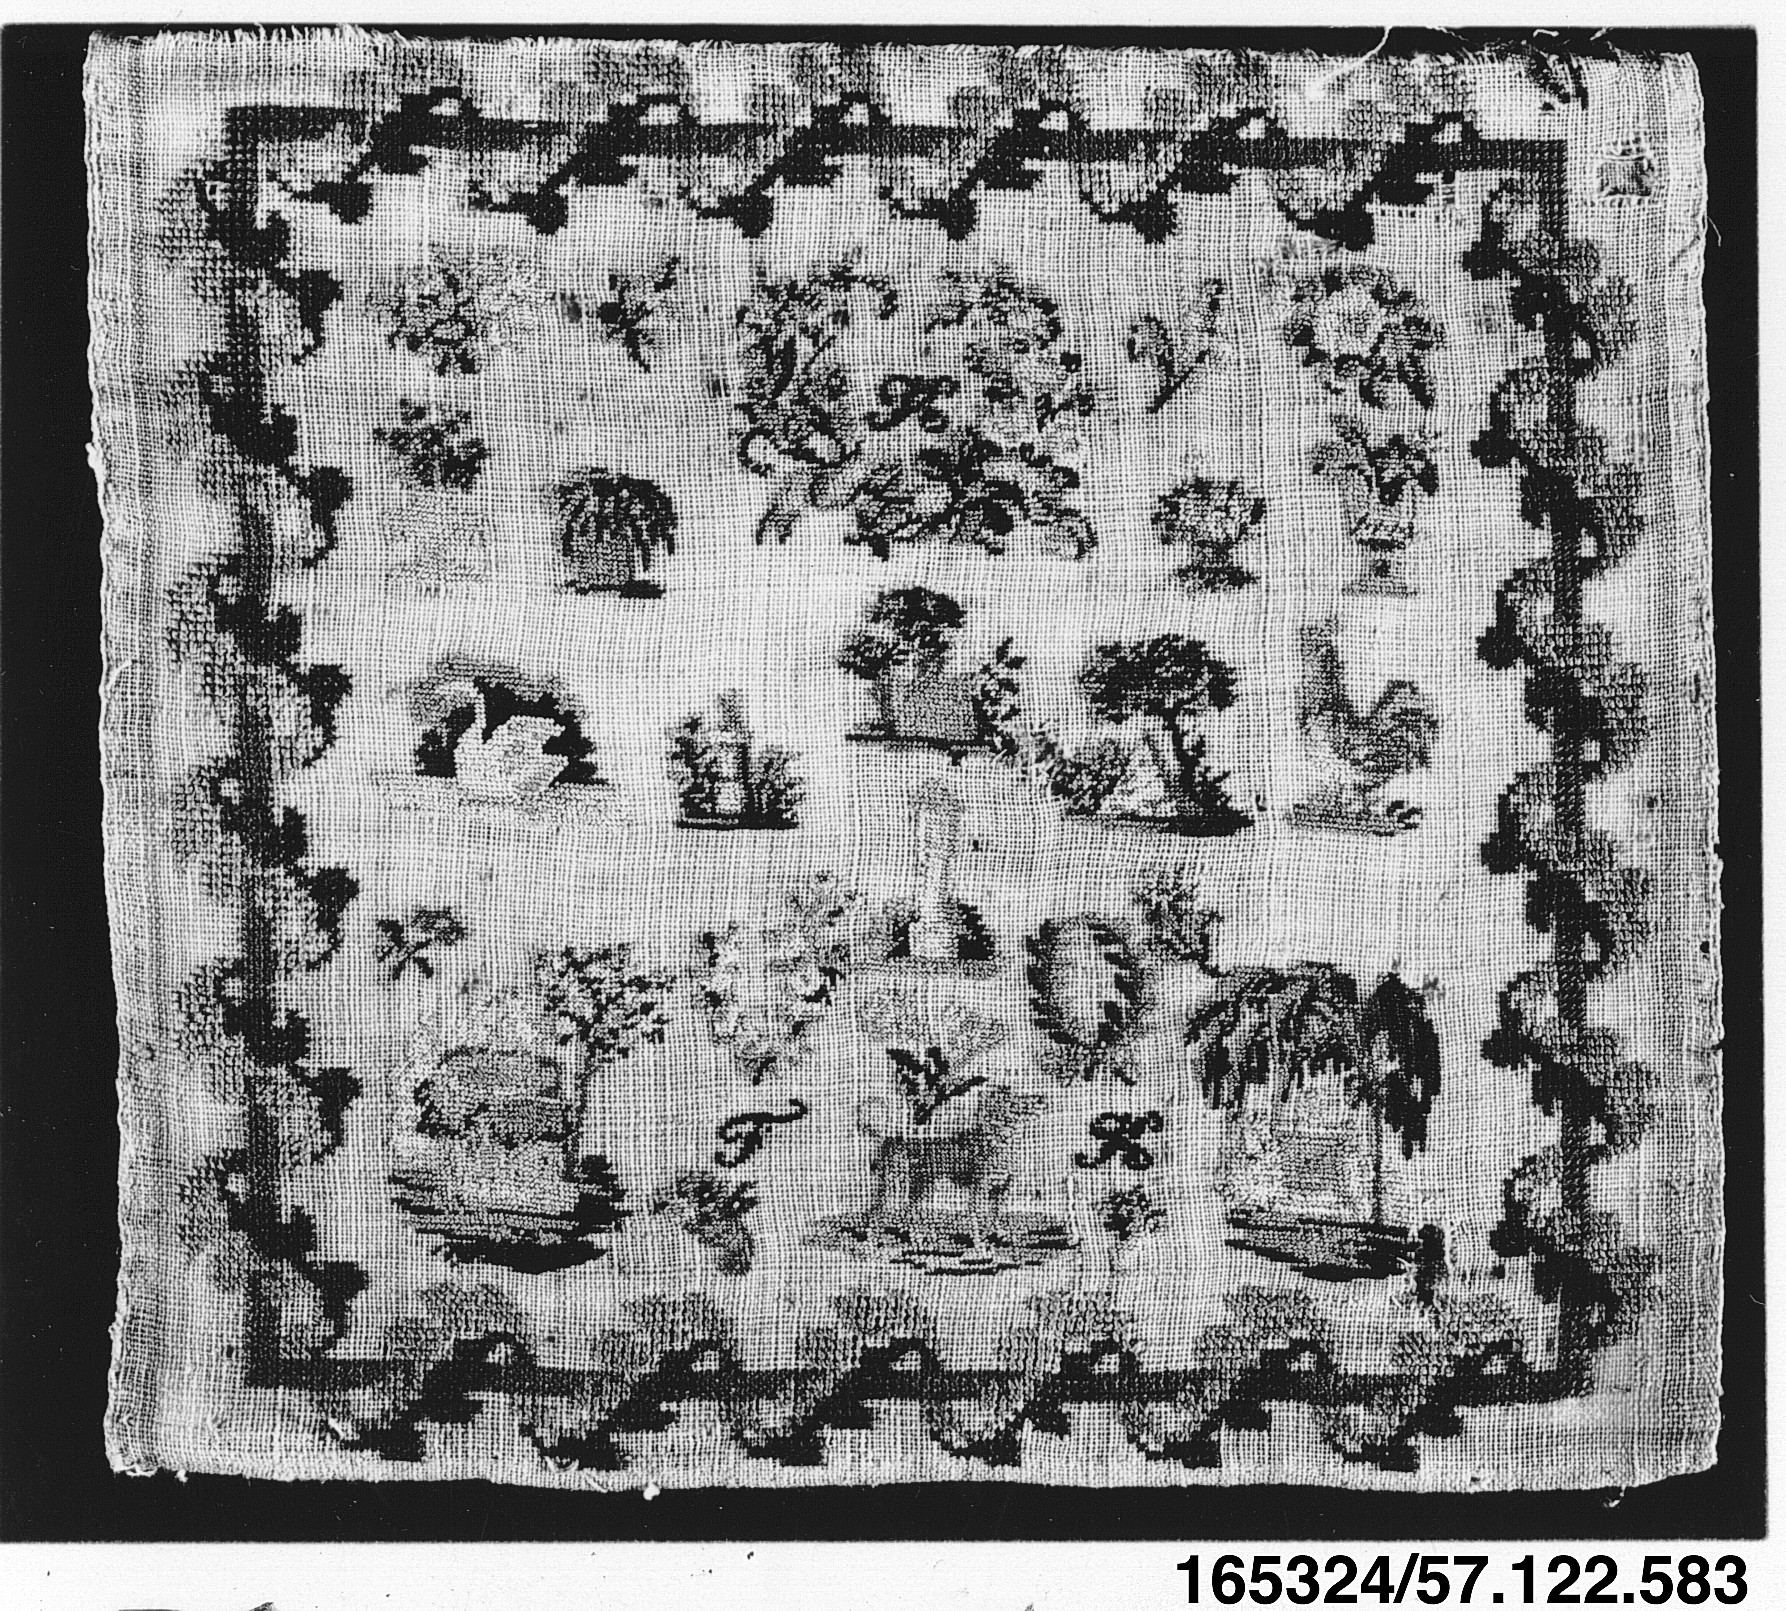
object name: sampler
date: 1801-1900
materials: silk, wool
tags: chickens,swans,dogs,flowers